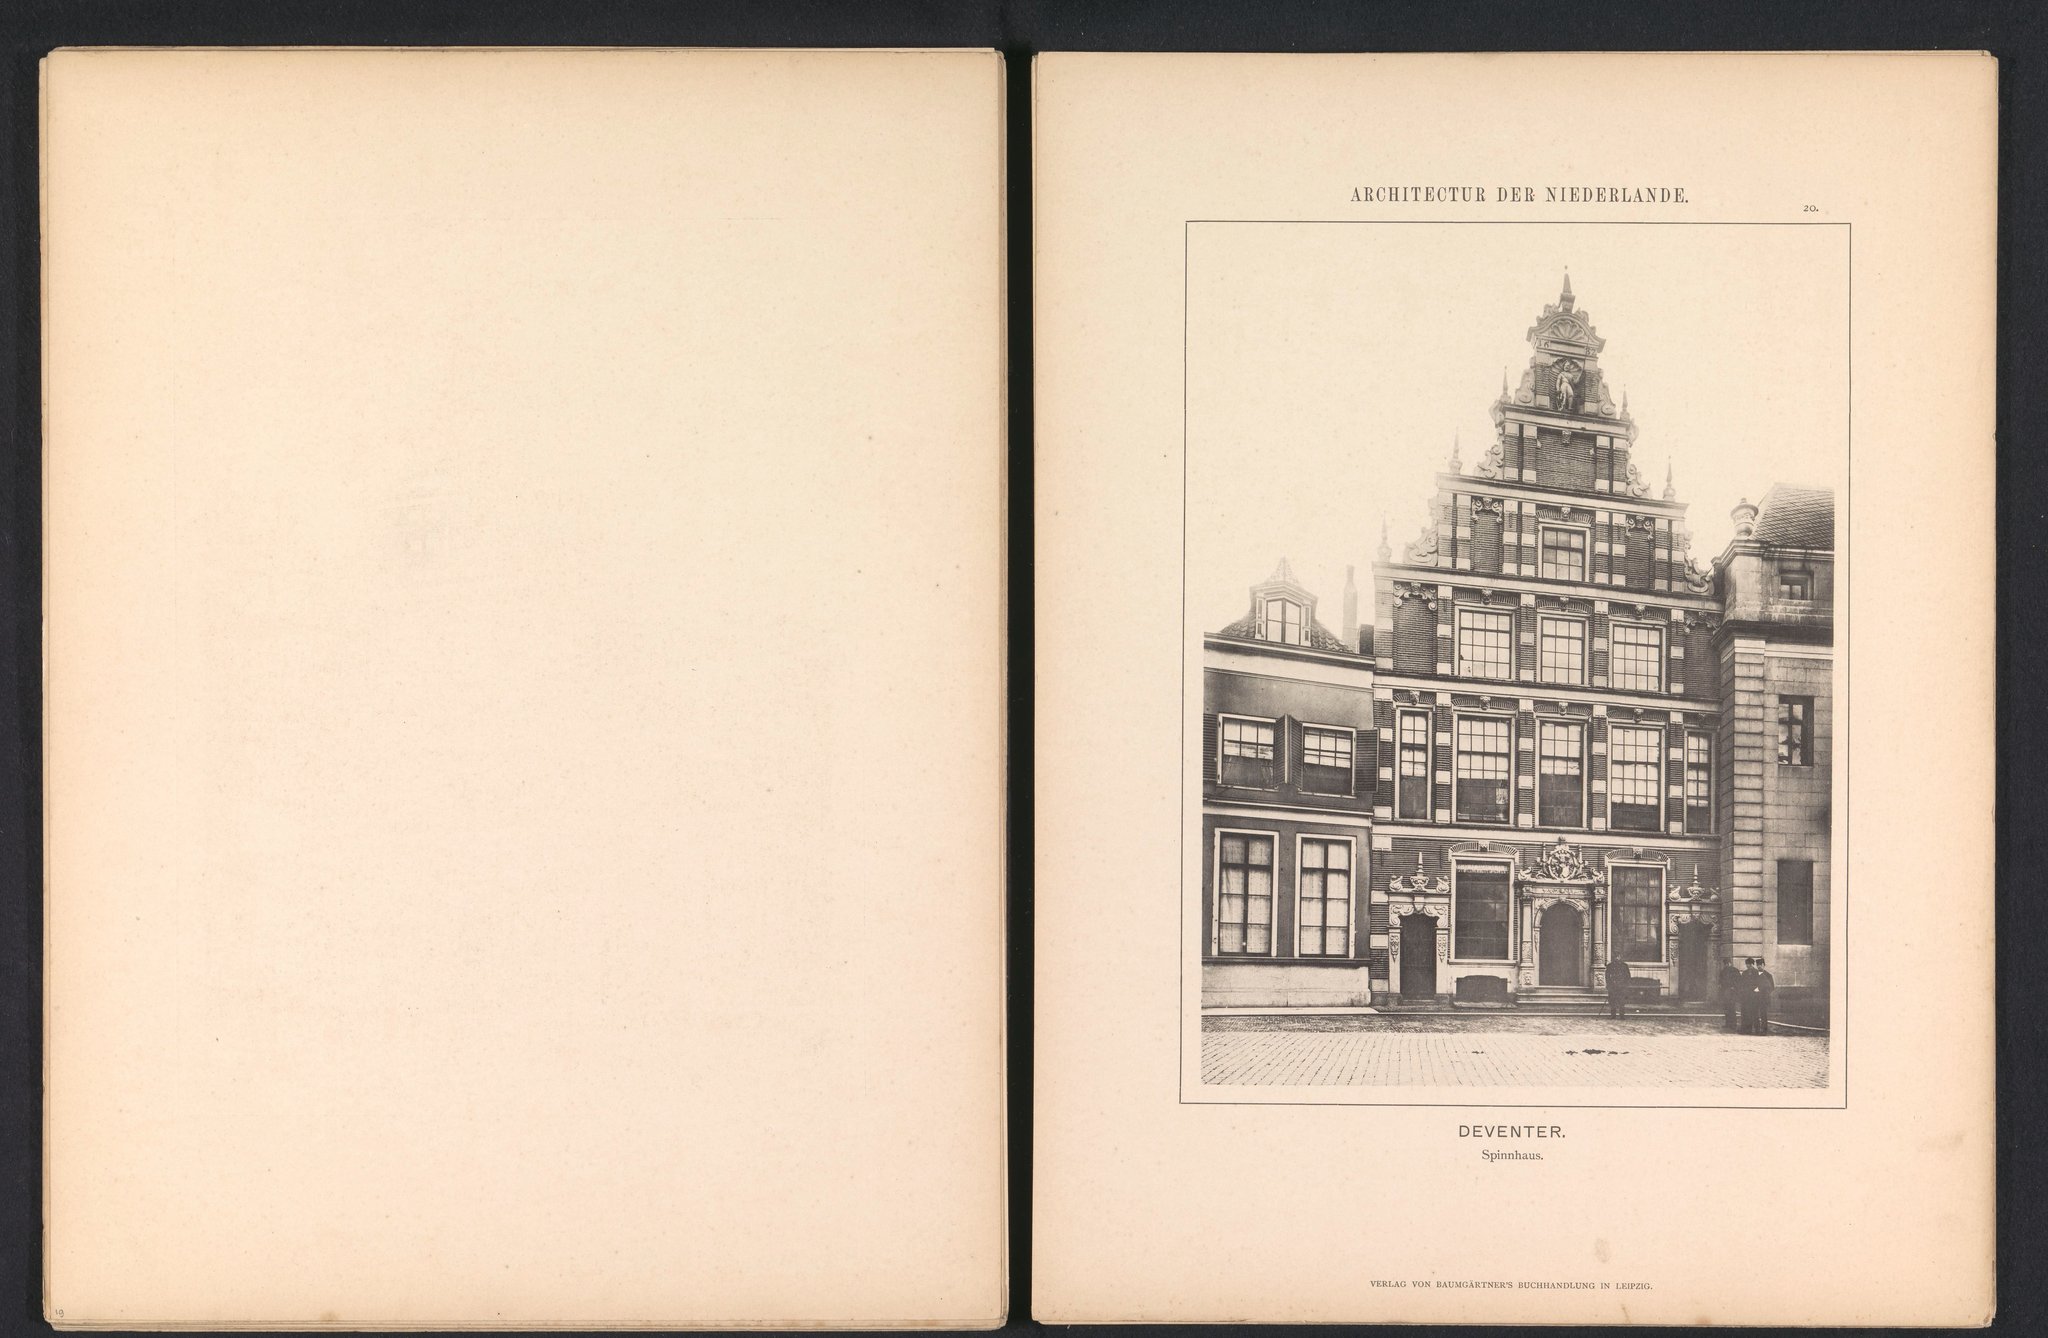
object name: photomechanical print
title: Gezicht op het vrouwentuchthuis in Deventer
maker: Anonymous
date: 1884-1894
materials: paper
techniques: photograph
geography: leipzig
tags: façade (of house or building), deventer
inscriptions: number: ‘20.’